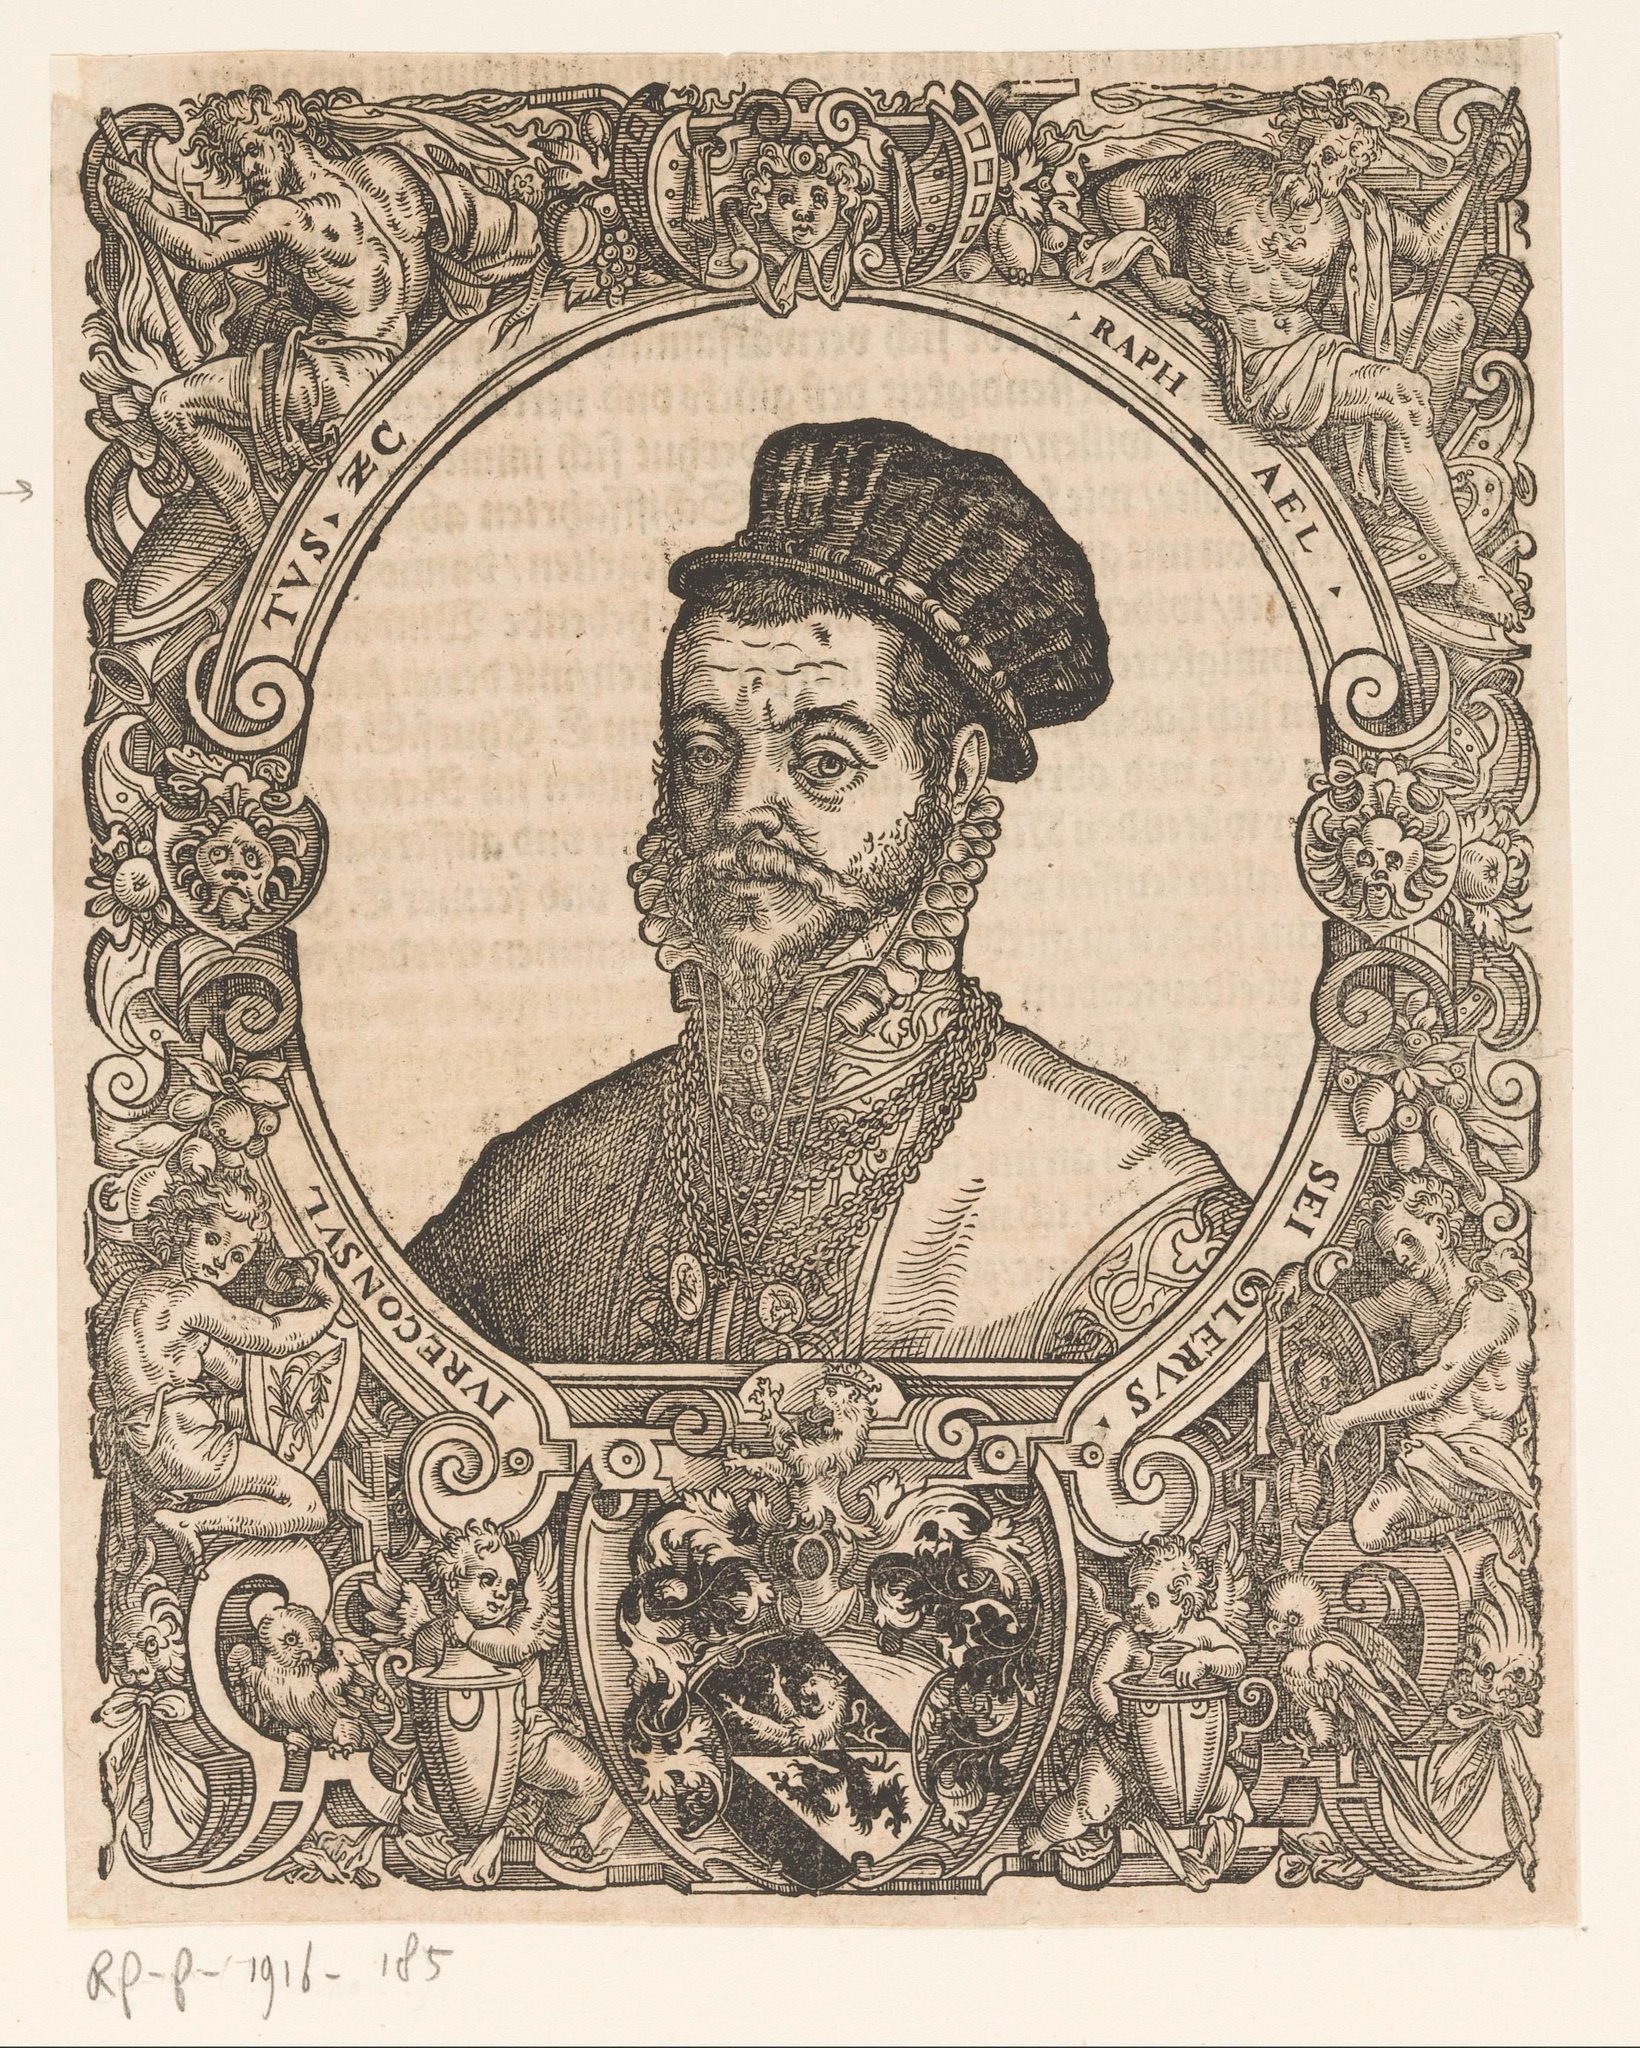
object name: book illustration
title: Portret van Raphael Seiler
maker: tobias stimmer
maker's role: draughtsman, painter, print maker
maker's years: 1539-1584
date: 1572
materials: paper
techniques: woodcut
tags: historical persons, armorial bearing, heraldry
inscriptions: collector's mark: Lugt 2228